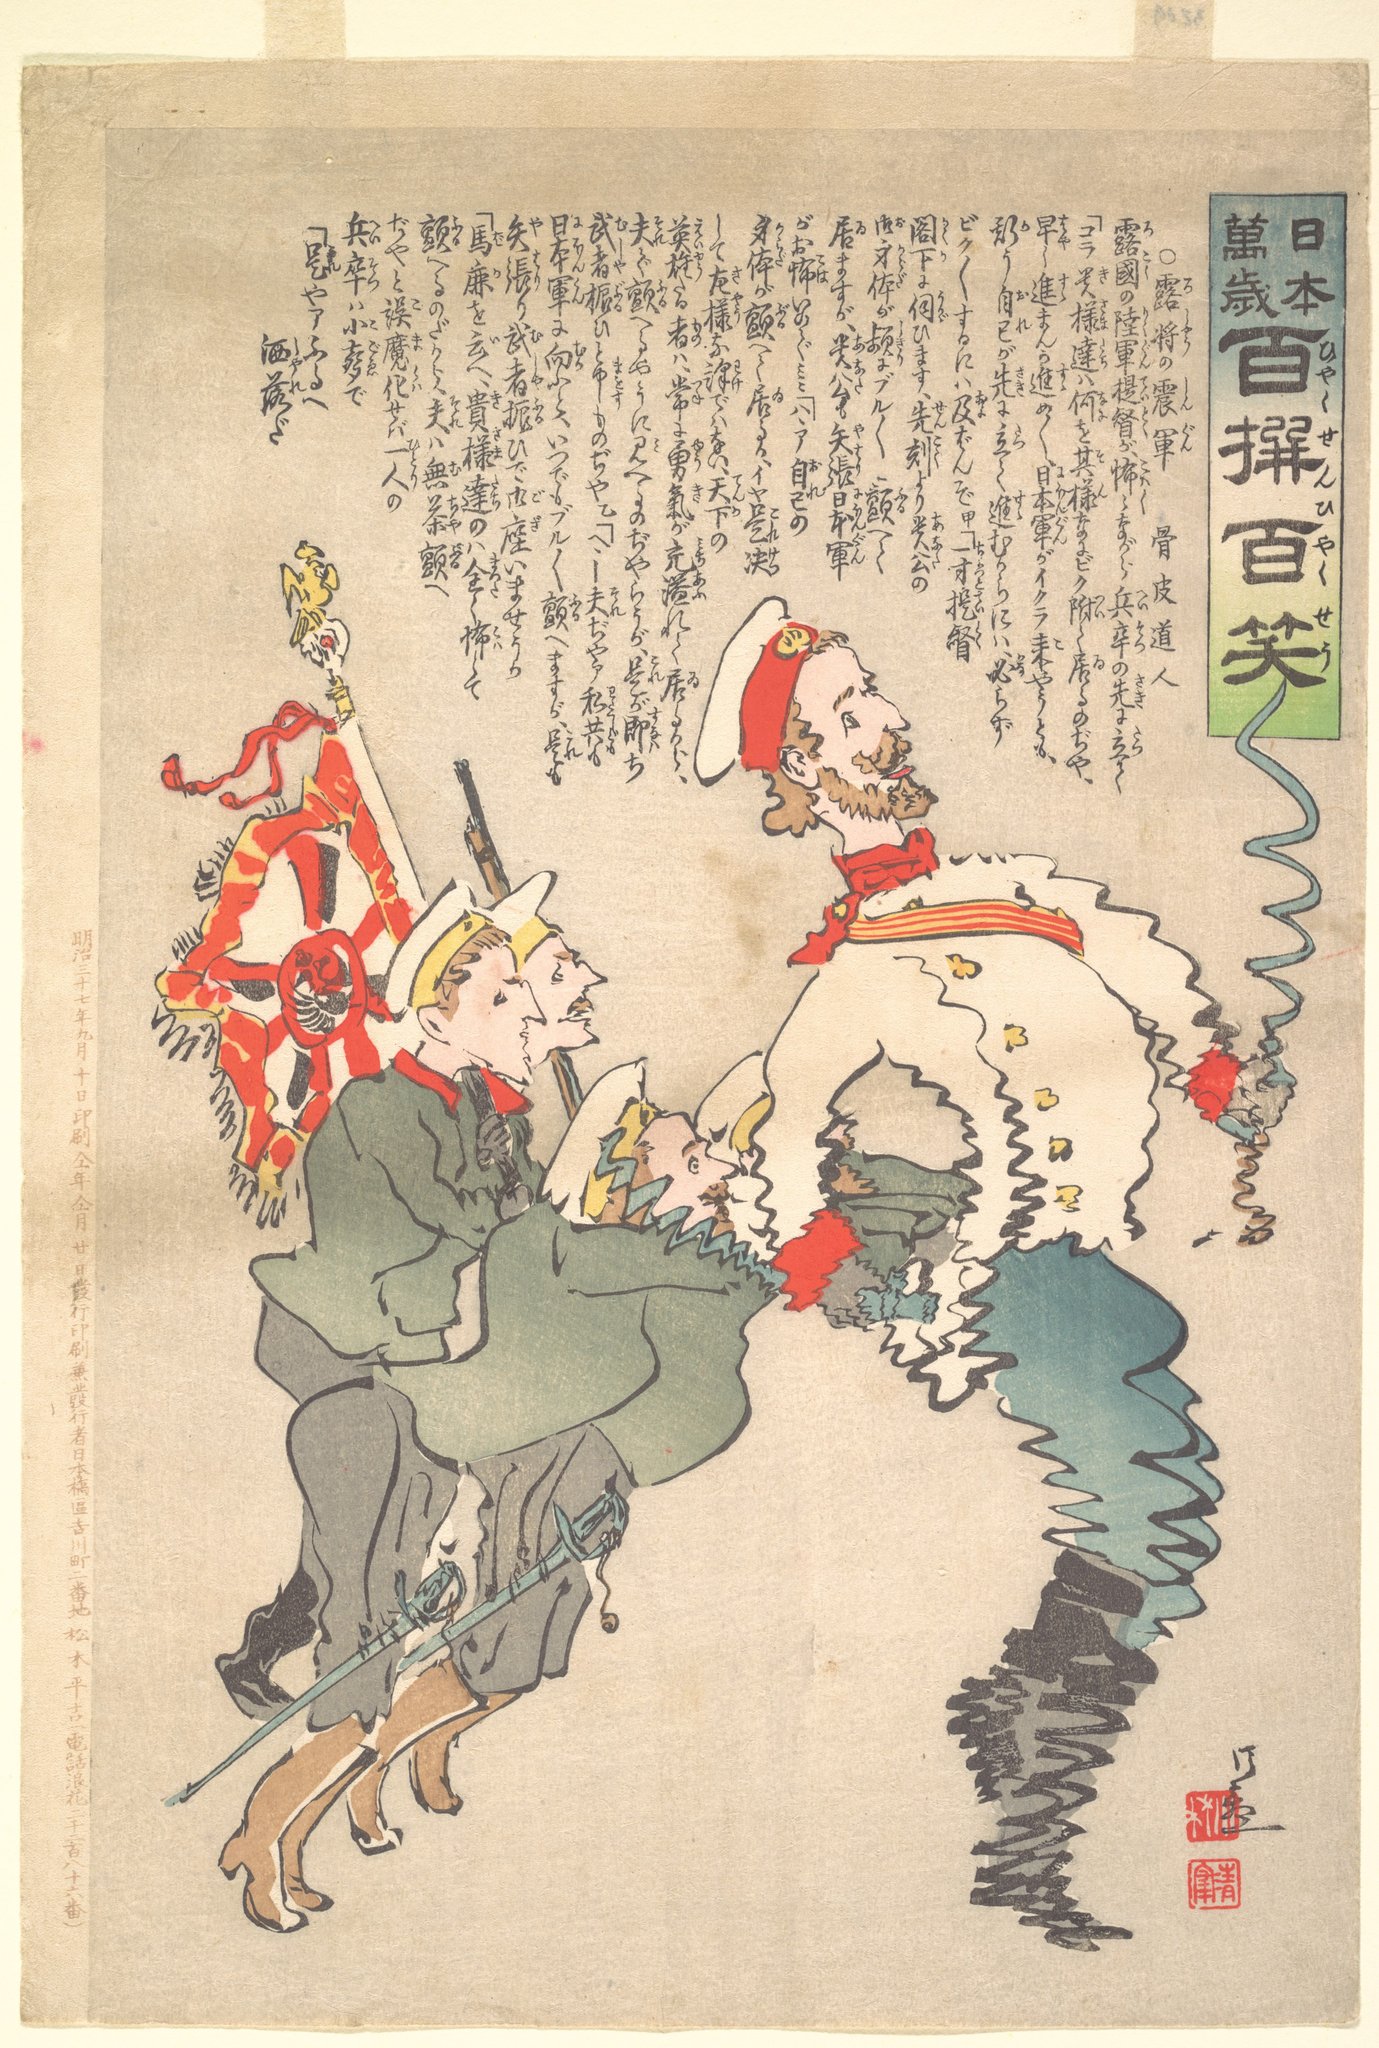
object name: print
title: Print from the series Long Live Japan: One Hundred Victories, One Hundred Laughs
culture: japanese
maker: kobayashi kiyochika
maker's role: artist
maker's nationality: japanese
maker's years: 1847-1915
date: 1904-1905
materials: ink, paper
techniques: nishiki e, woodblock print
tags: army,swords,flags